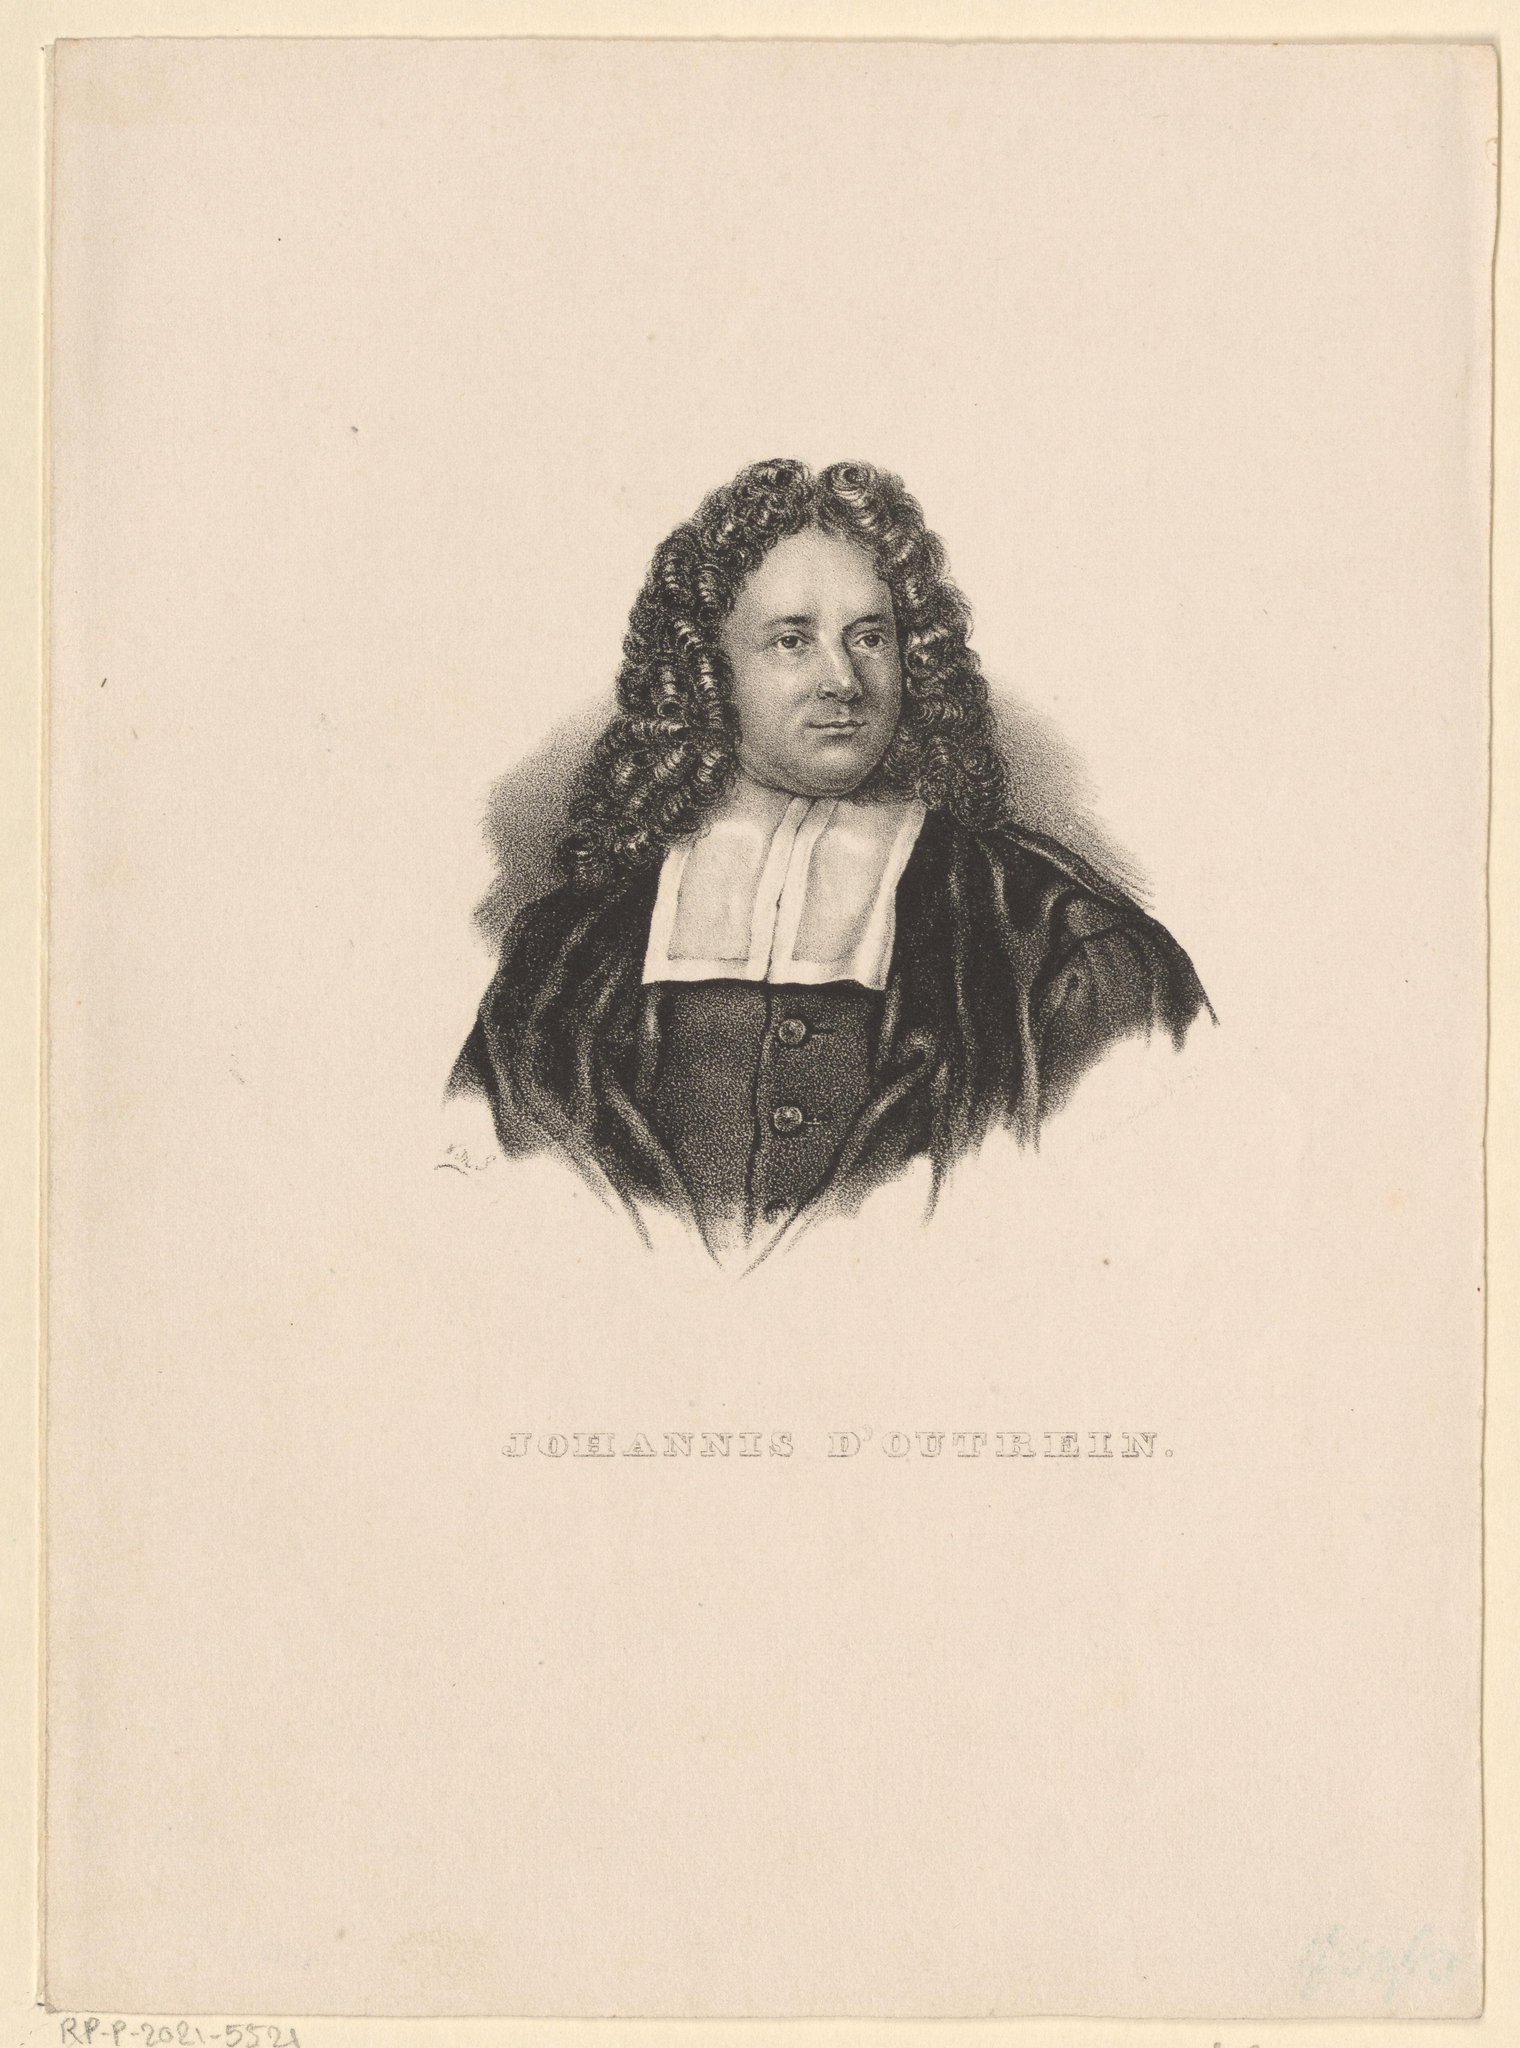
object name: print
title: Portret van Johannes d'Outrein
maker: nicolaas martinus schild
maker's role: draughtsman, print maker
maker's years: 1822-1840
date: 1830-1845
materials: paper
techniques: lithograph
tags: middelburg, amsterdam, historical persons